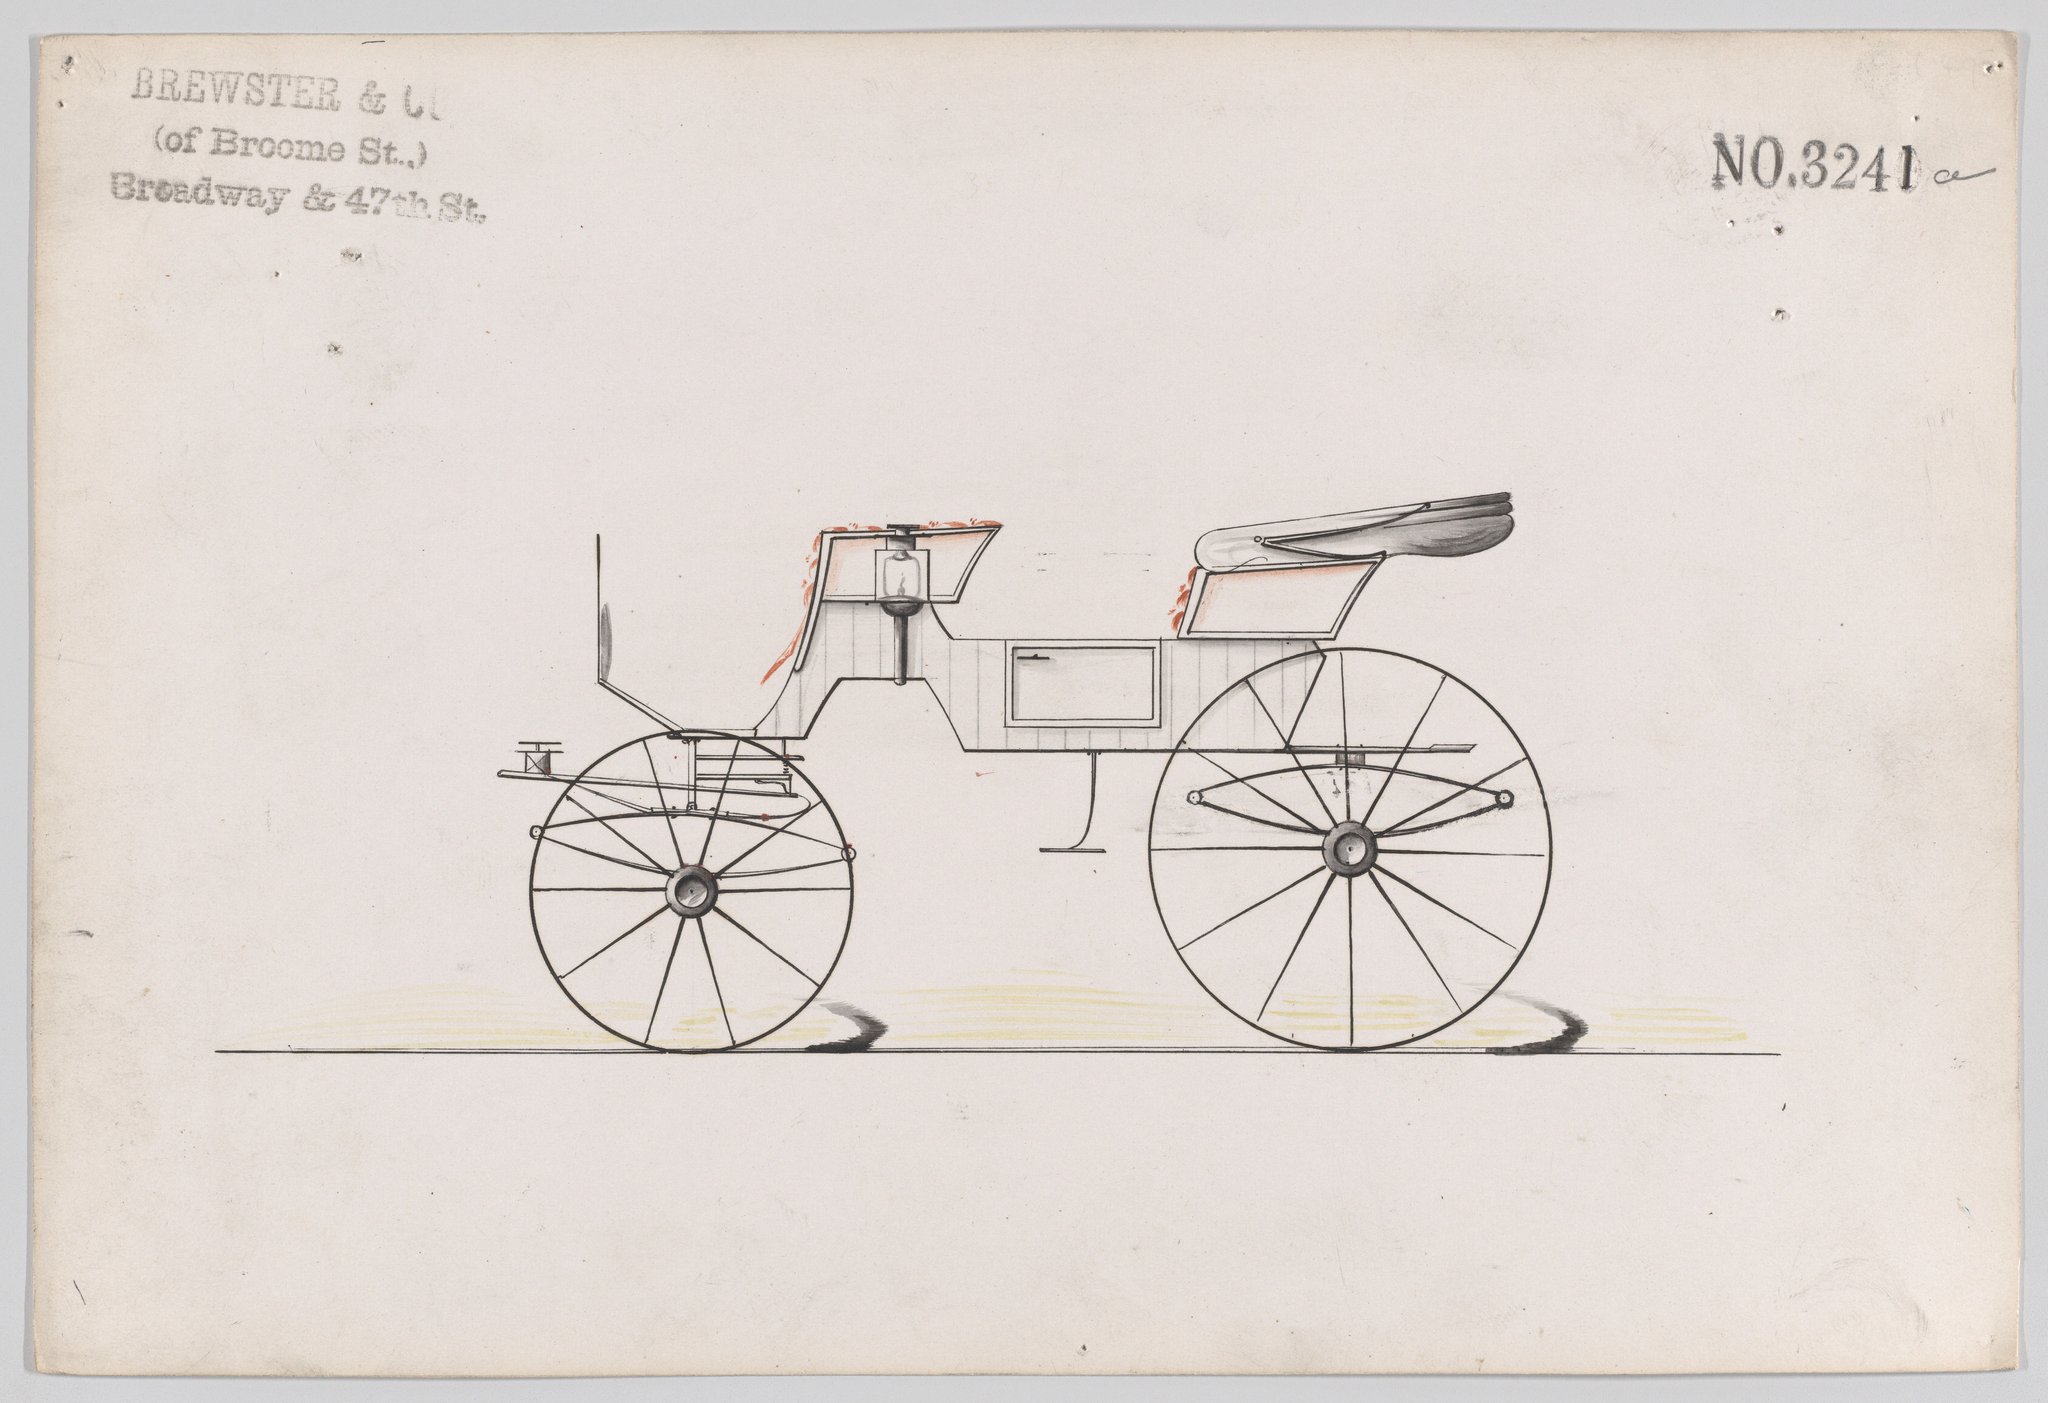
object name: drawing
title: Design for Park or Cabriolet Phaeton, no. 3241a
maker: brewster & co.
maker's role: manufacturer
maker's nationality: american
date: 1876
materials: gouache, ink, watercolor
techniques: pen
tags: carriages